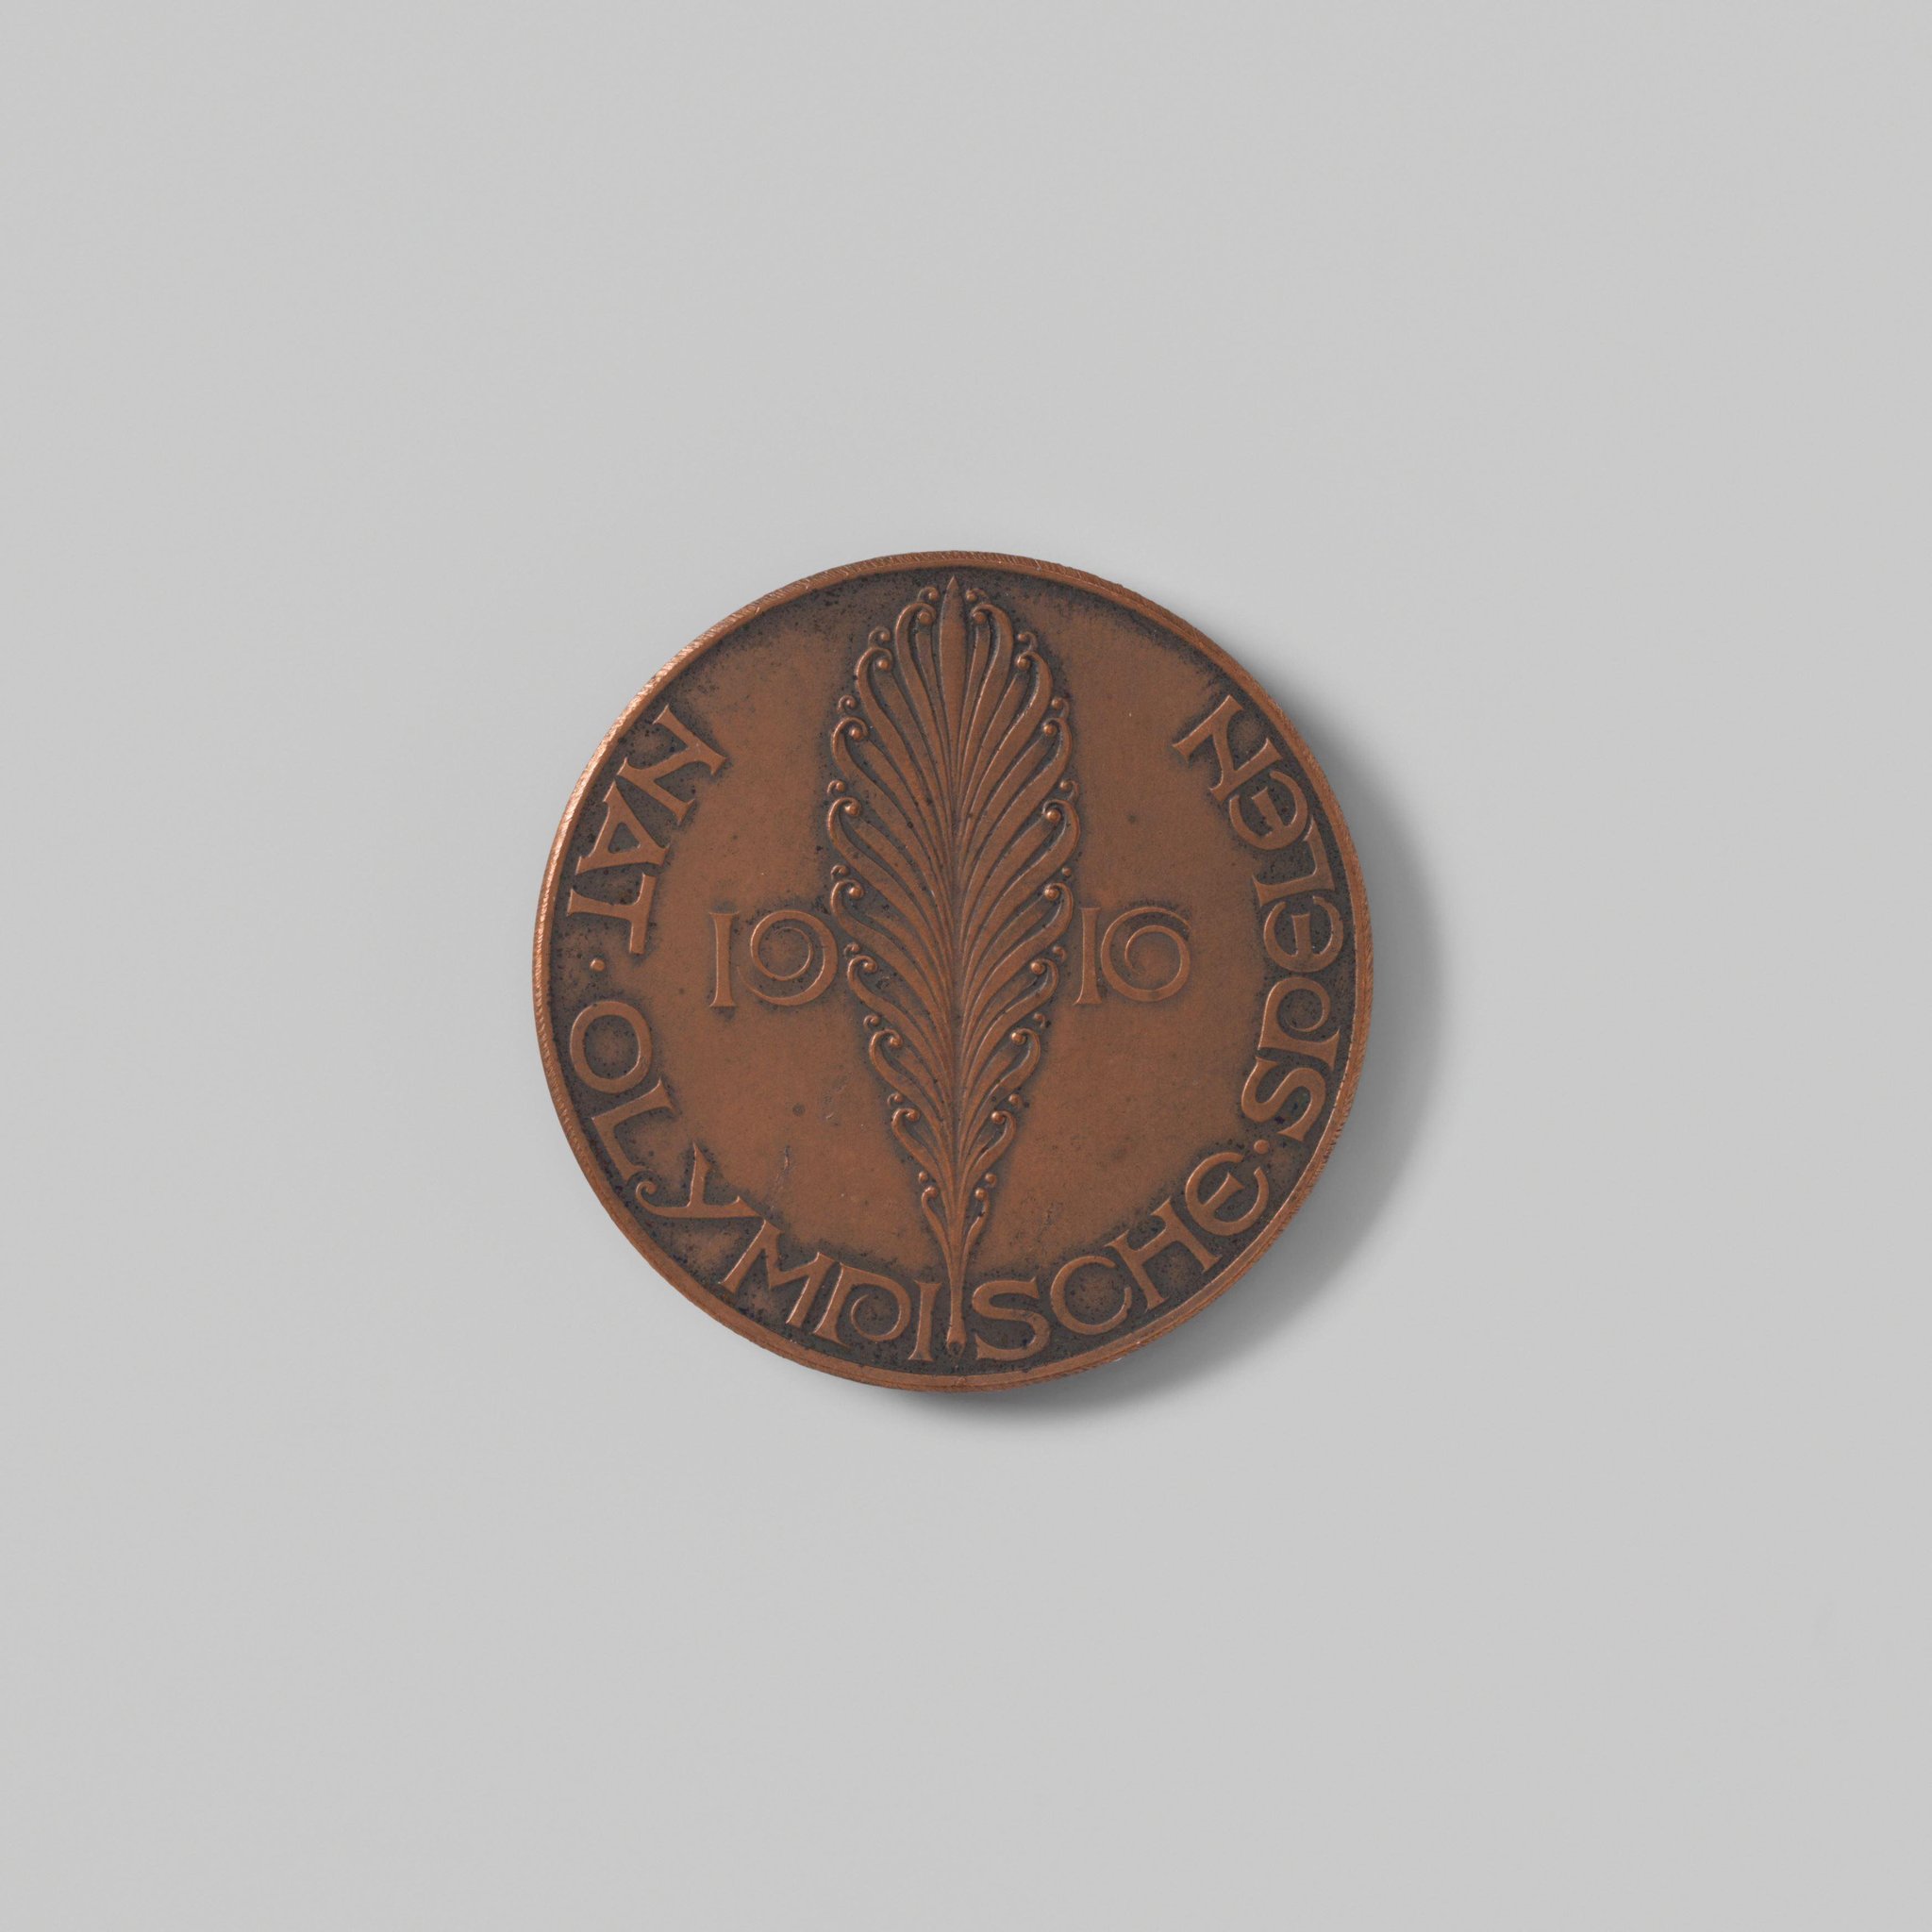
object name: medal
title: Herinneringspenning Nederlands Olympisch Comité 1916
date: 1916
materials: bronze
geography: netherlands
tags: nederlands olympisch comité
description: Herinneringspenning in brons van het Nederlands Olympisch Comité, 1916, Nationale Olympische Spelen.